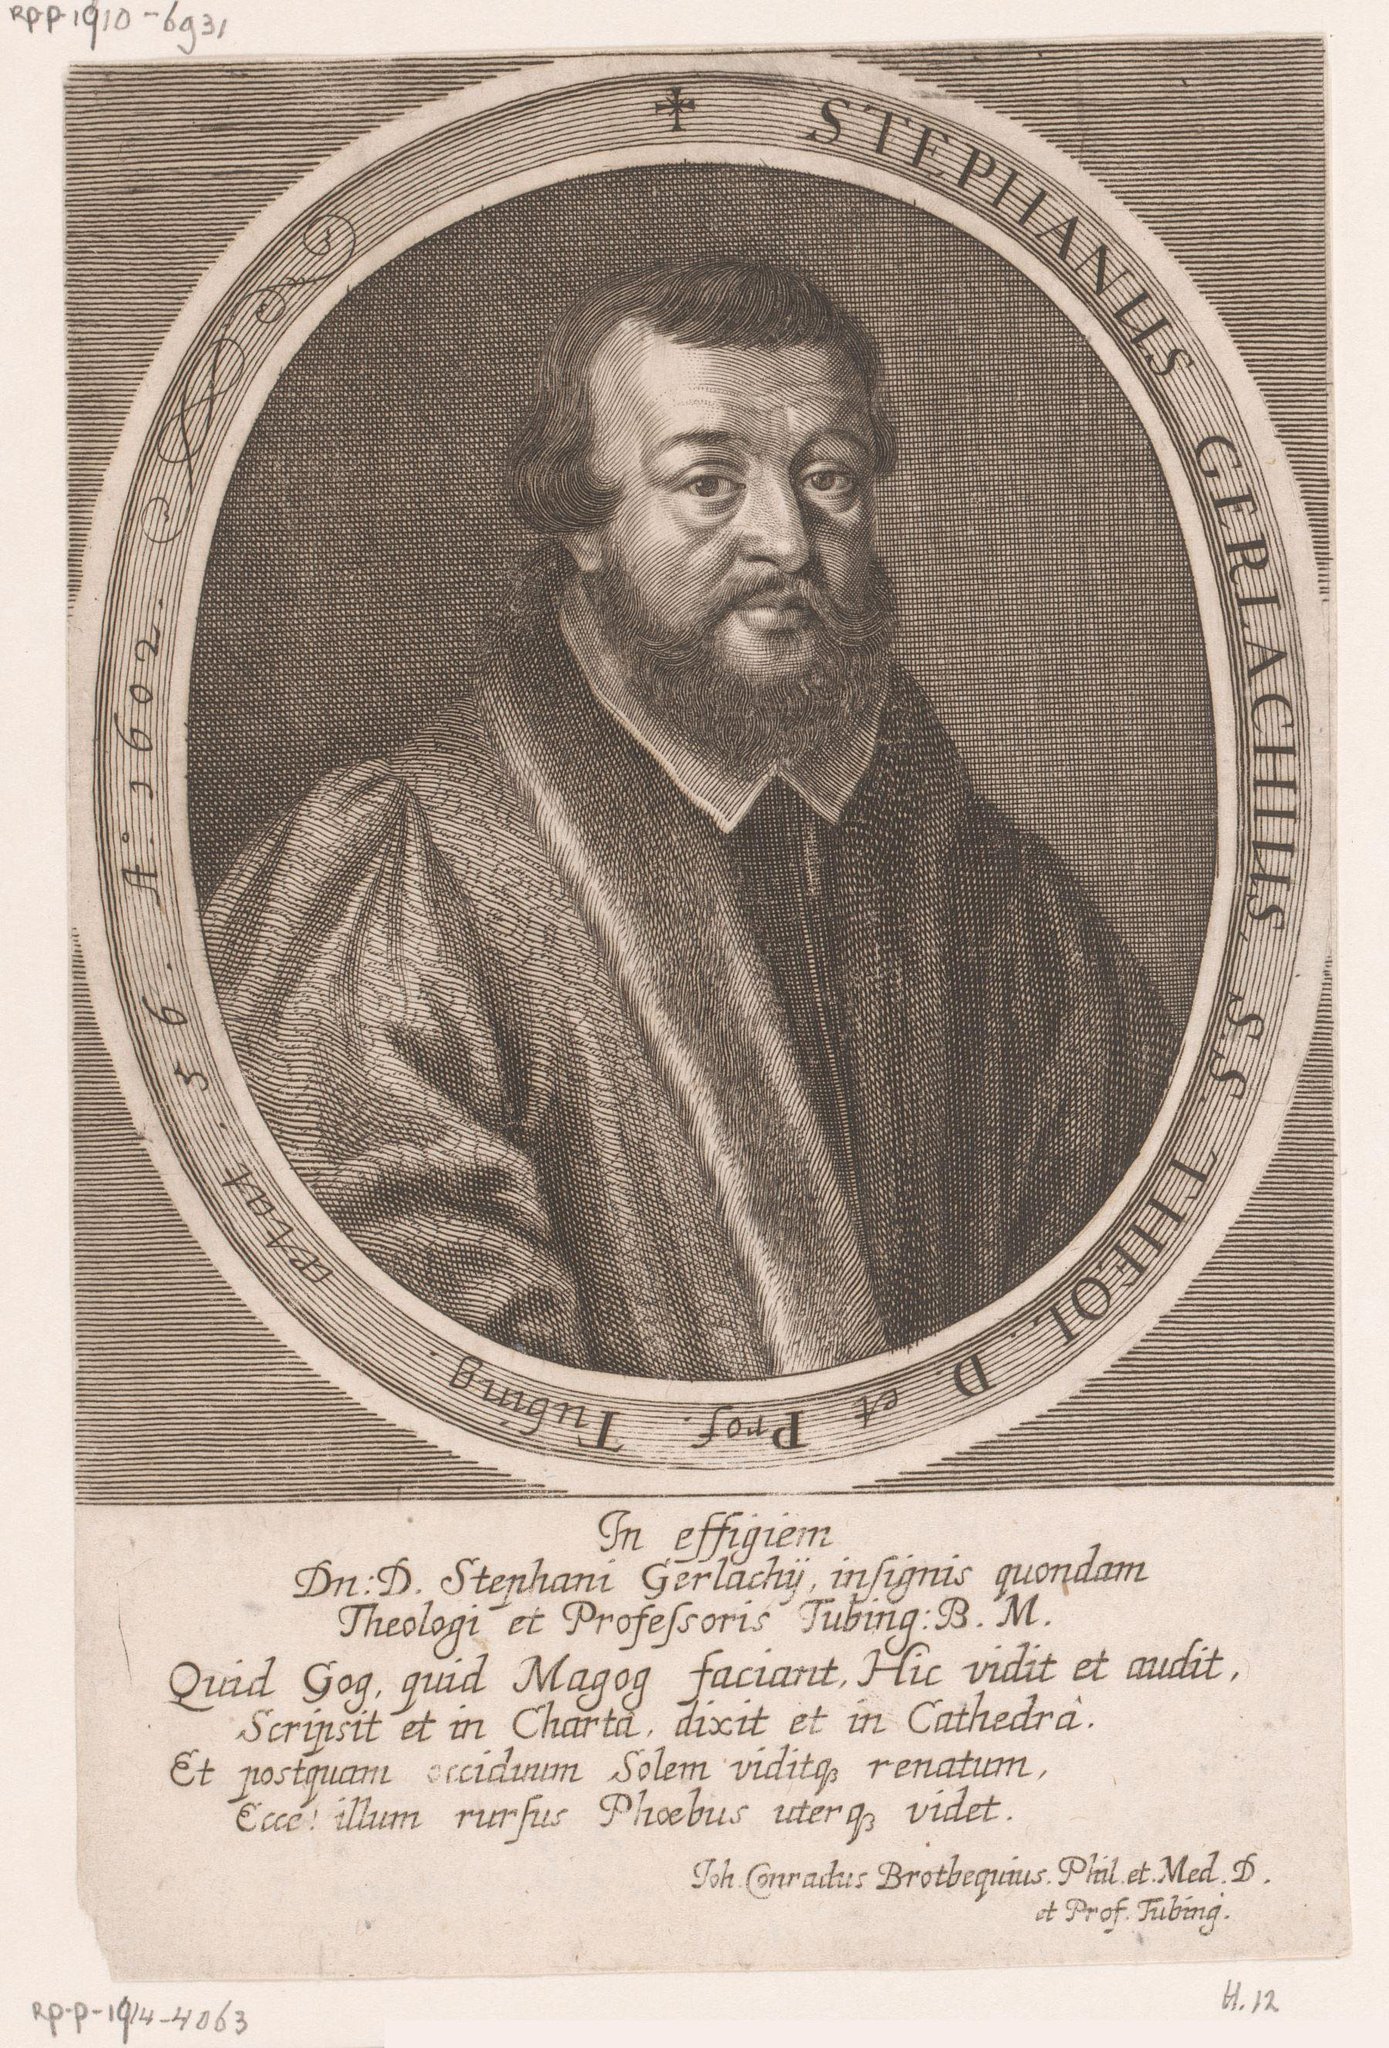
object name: print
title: Portret van Stephan Gerlach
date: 1635-1670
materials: paper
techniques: engraving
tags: historical persons, armorial bearing, heraldry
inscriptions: collector's mark: Lugt 2228